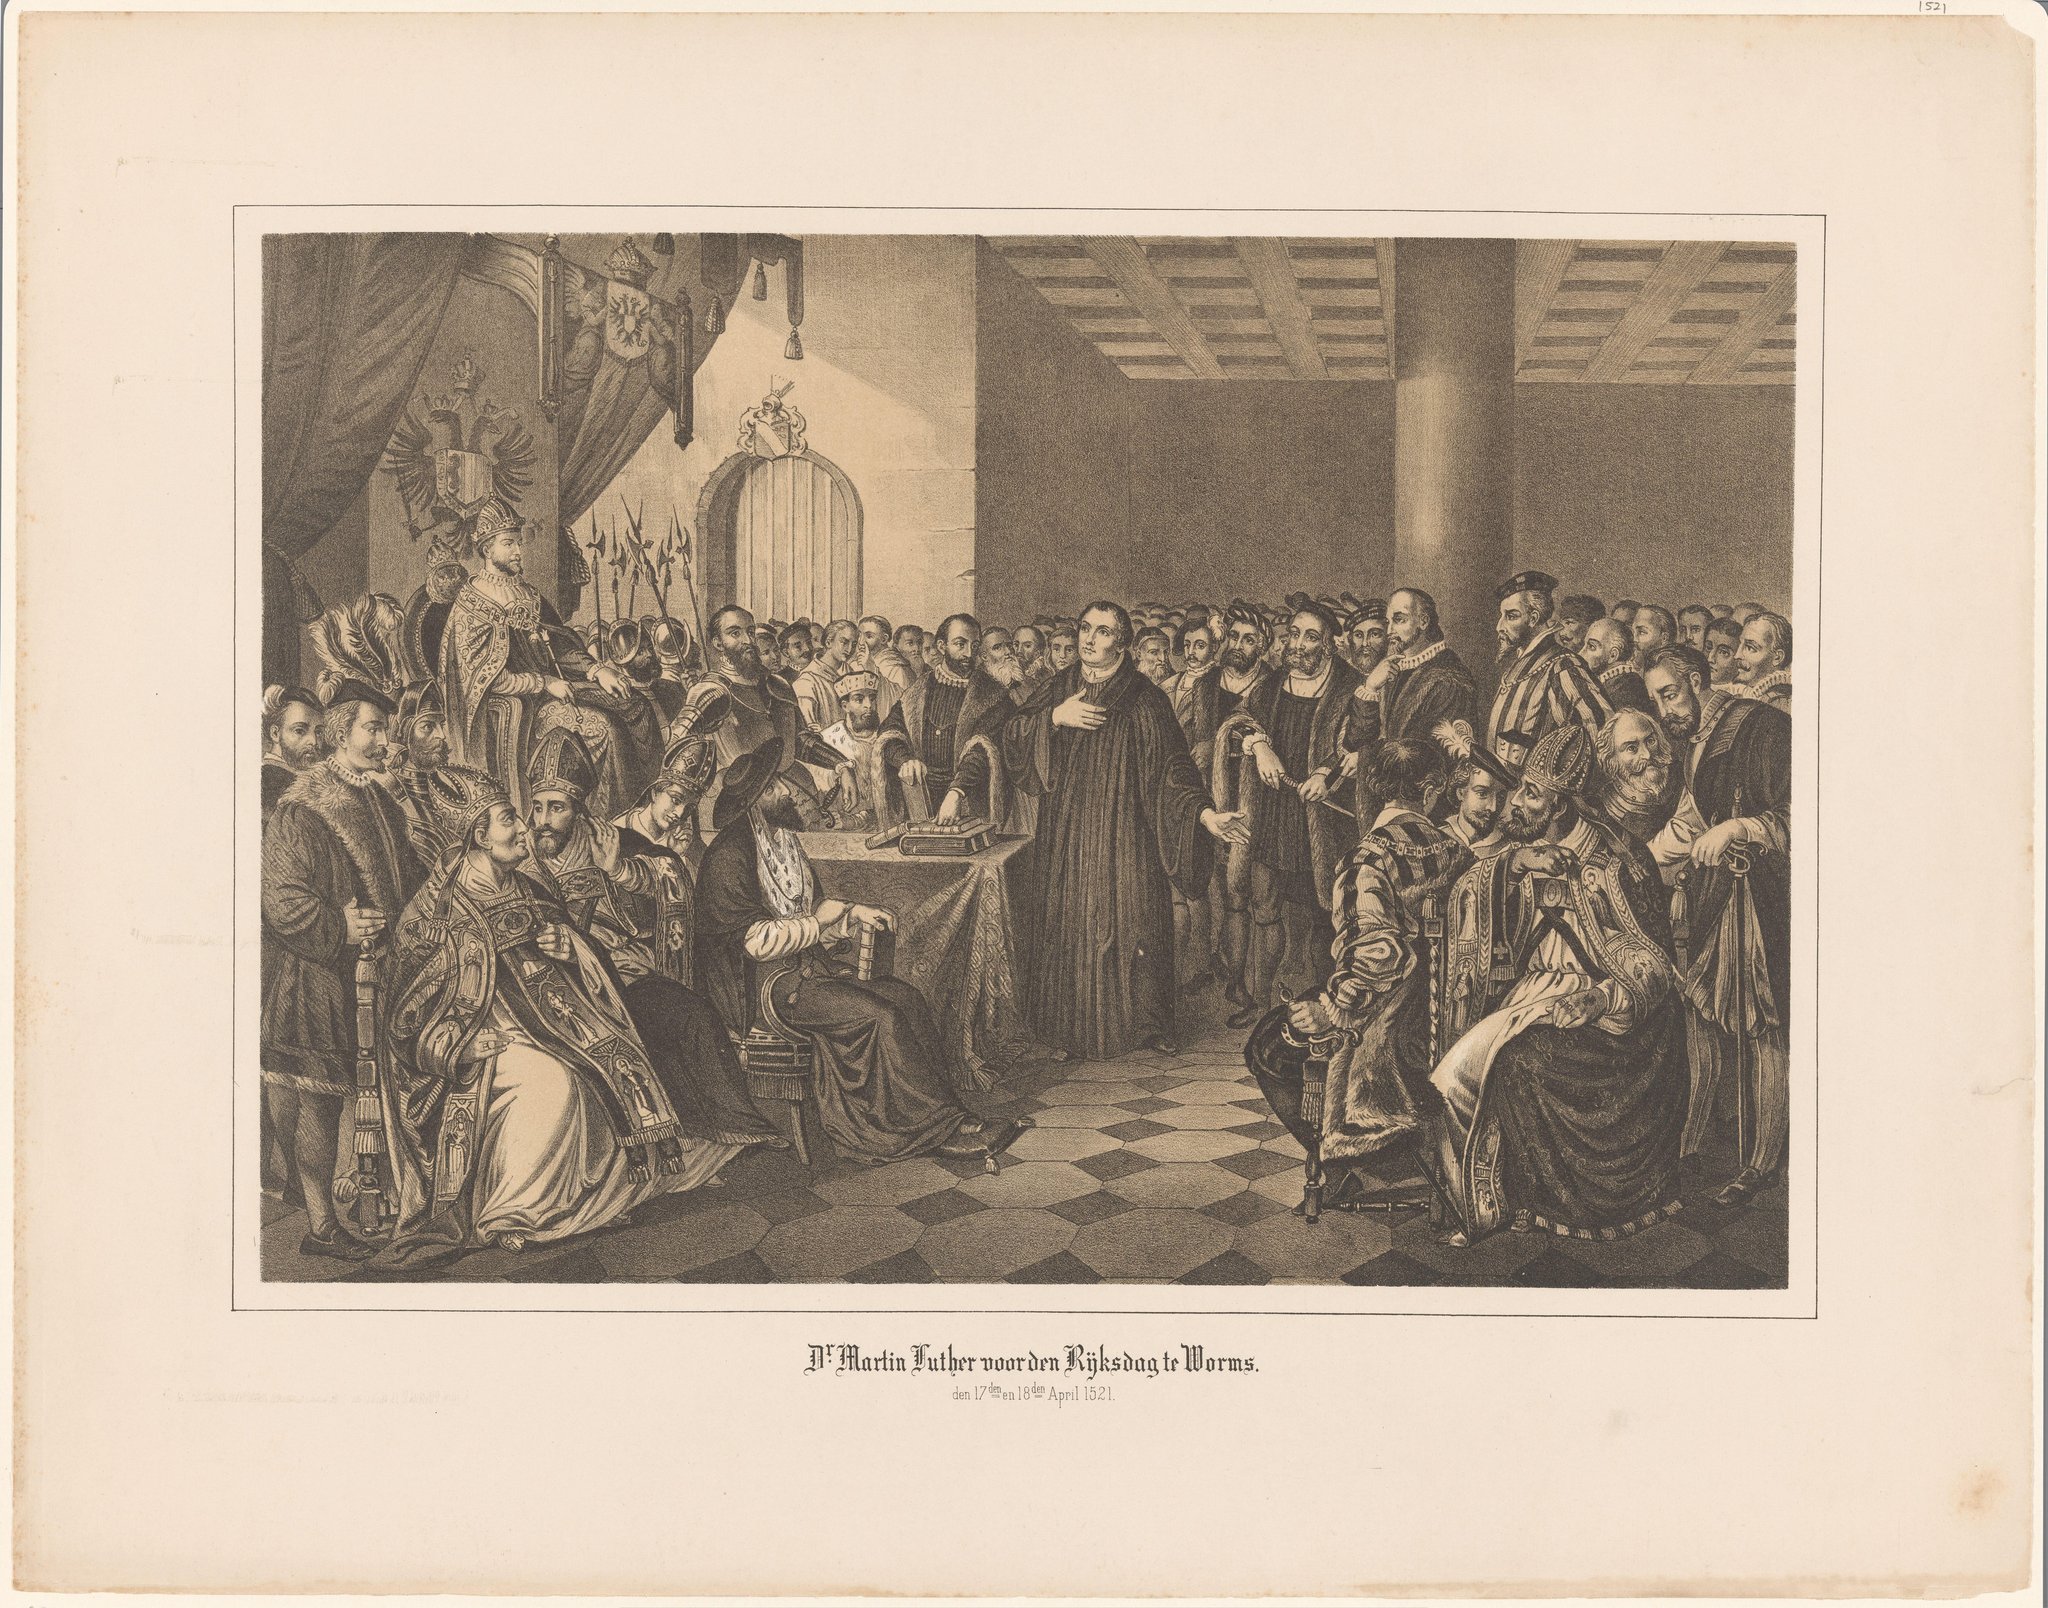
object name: print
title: Luther voor de Rijksdag te Worms, 1521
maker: Anonymous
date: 1800-1899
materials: paper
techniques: tone lithography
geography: netherlands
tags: priest, martin luther, charles v (holy roman emperor and king of spain), protestant confessions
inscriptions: collector's mark: Lugt 2233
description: Luther in de houding van 'Hier sta ik, ik kan niet anders', op de Rijksdag in Worms, 17-18 april 1521, in de zaal met links keizer Karel V.